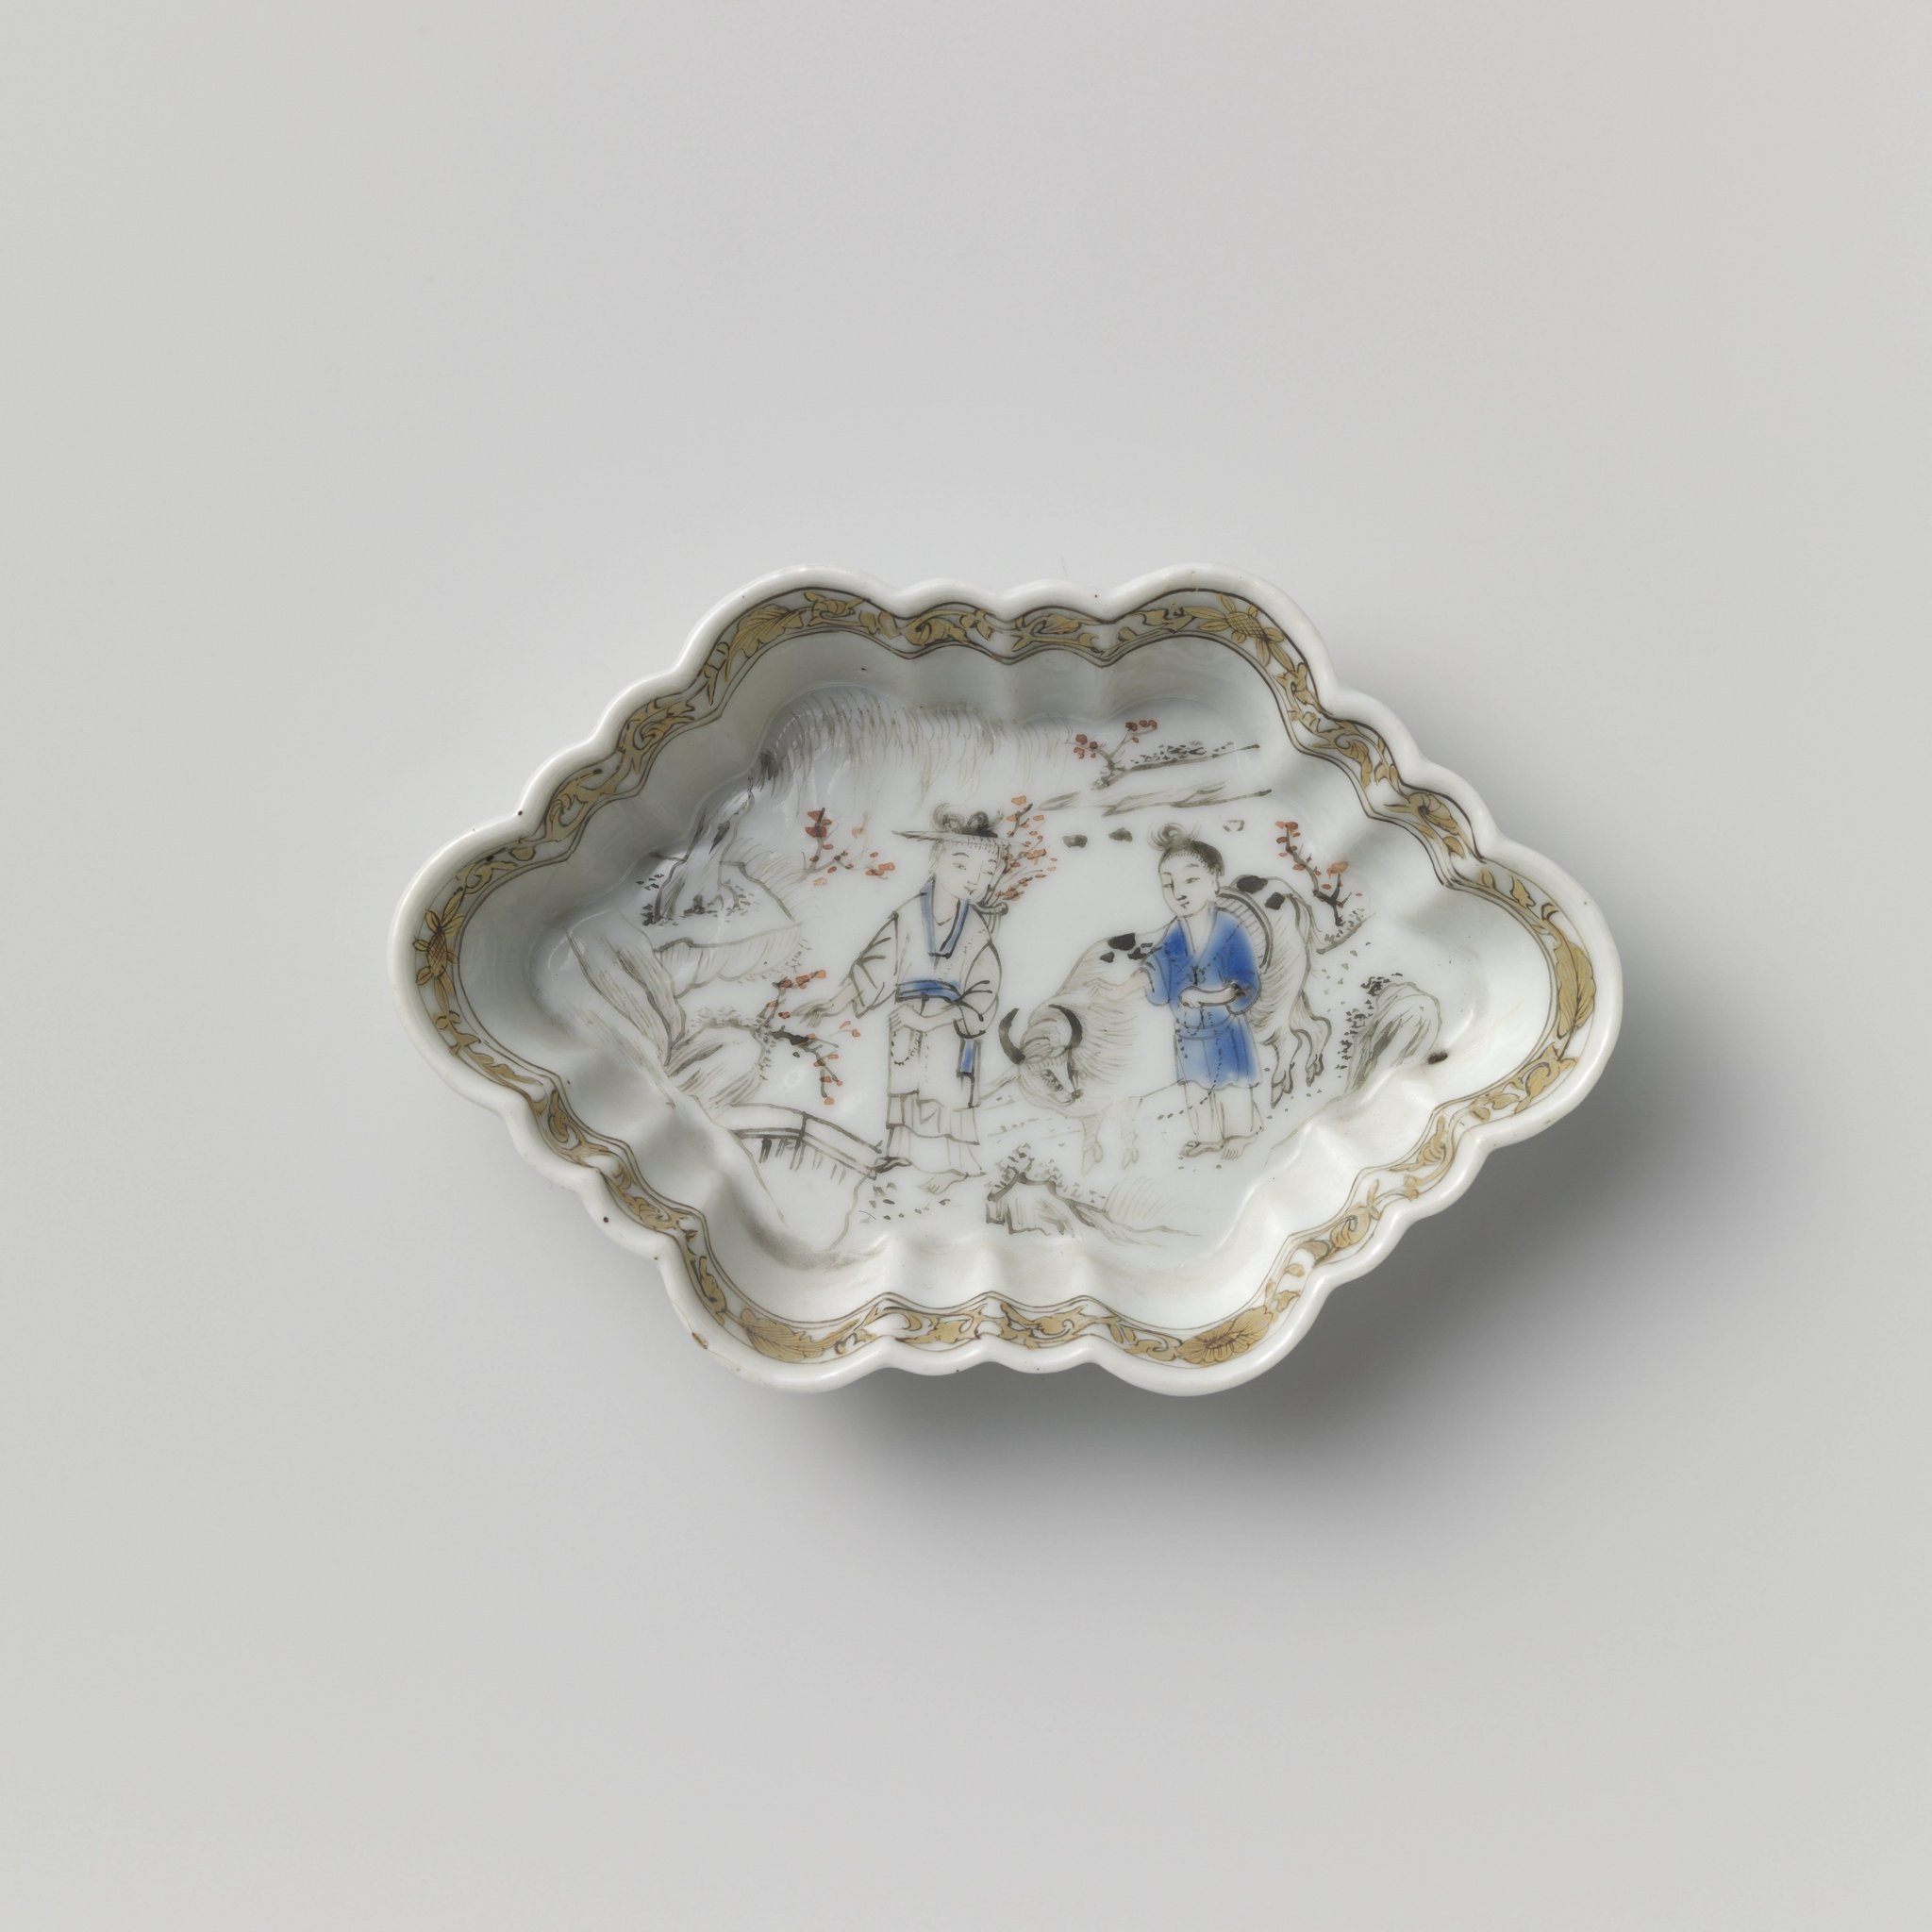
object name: pattipan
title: Spoon tray with two schepherds with an ox in a water landscape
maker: Anonymous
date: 1725-1749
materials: glaze, gold, paint, porcelain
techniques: firing, forming, gilding, vitrification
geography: china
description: Schotel, met gekartelde rand, met chinese figuren in zwart blauw en rood.